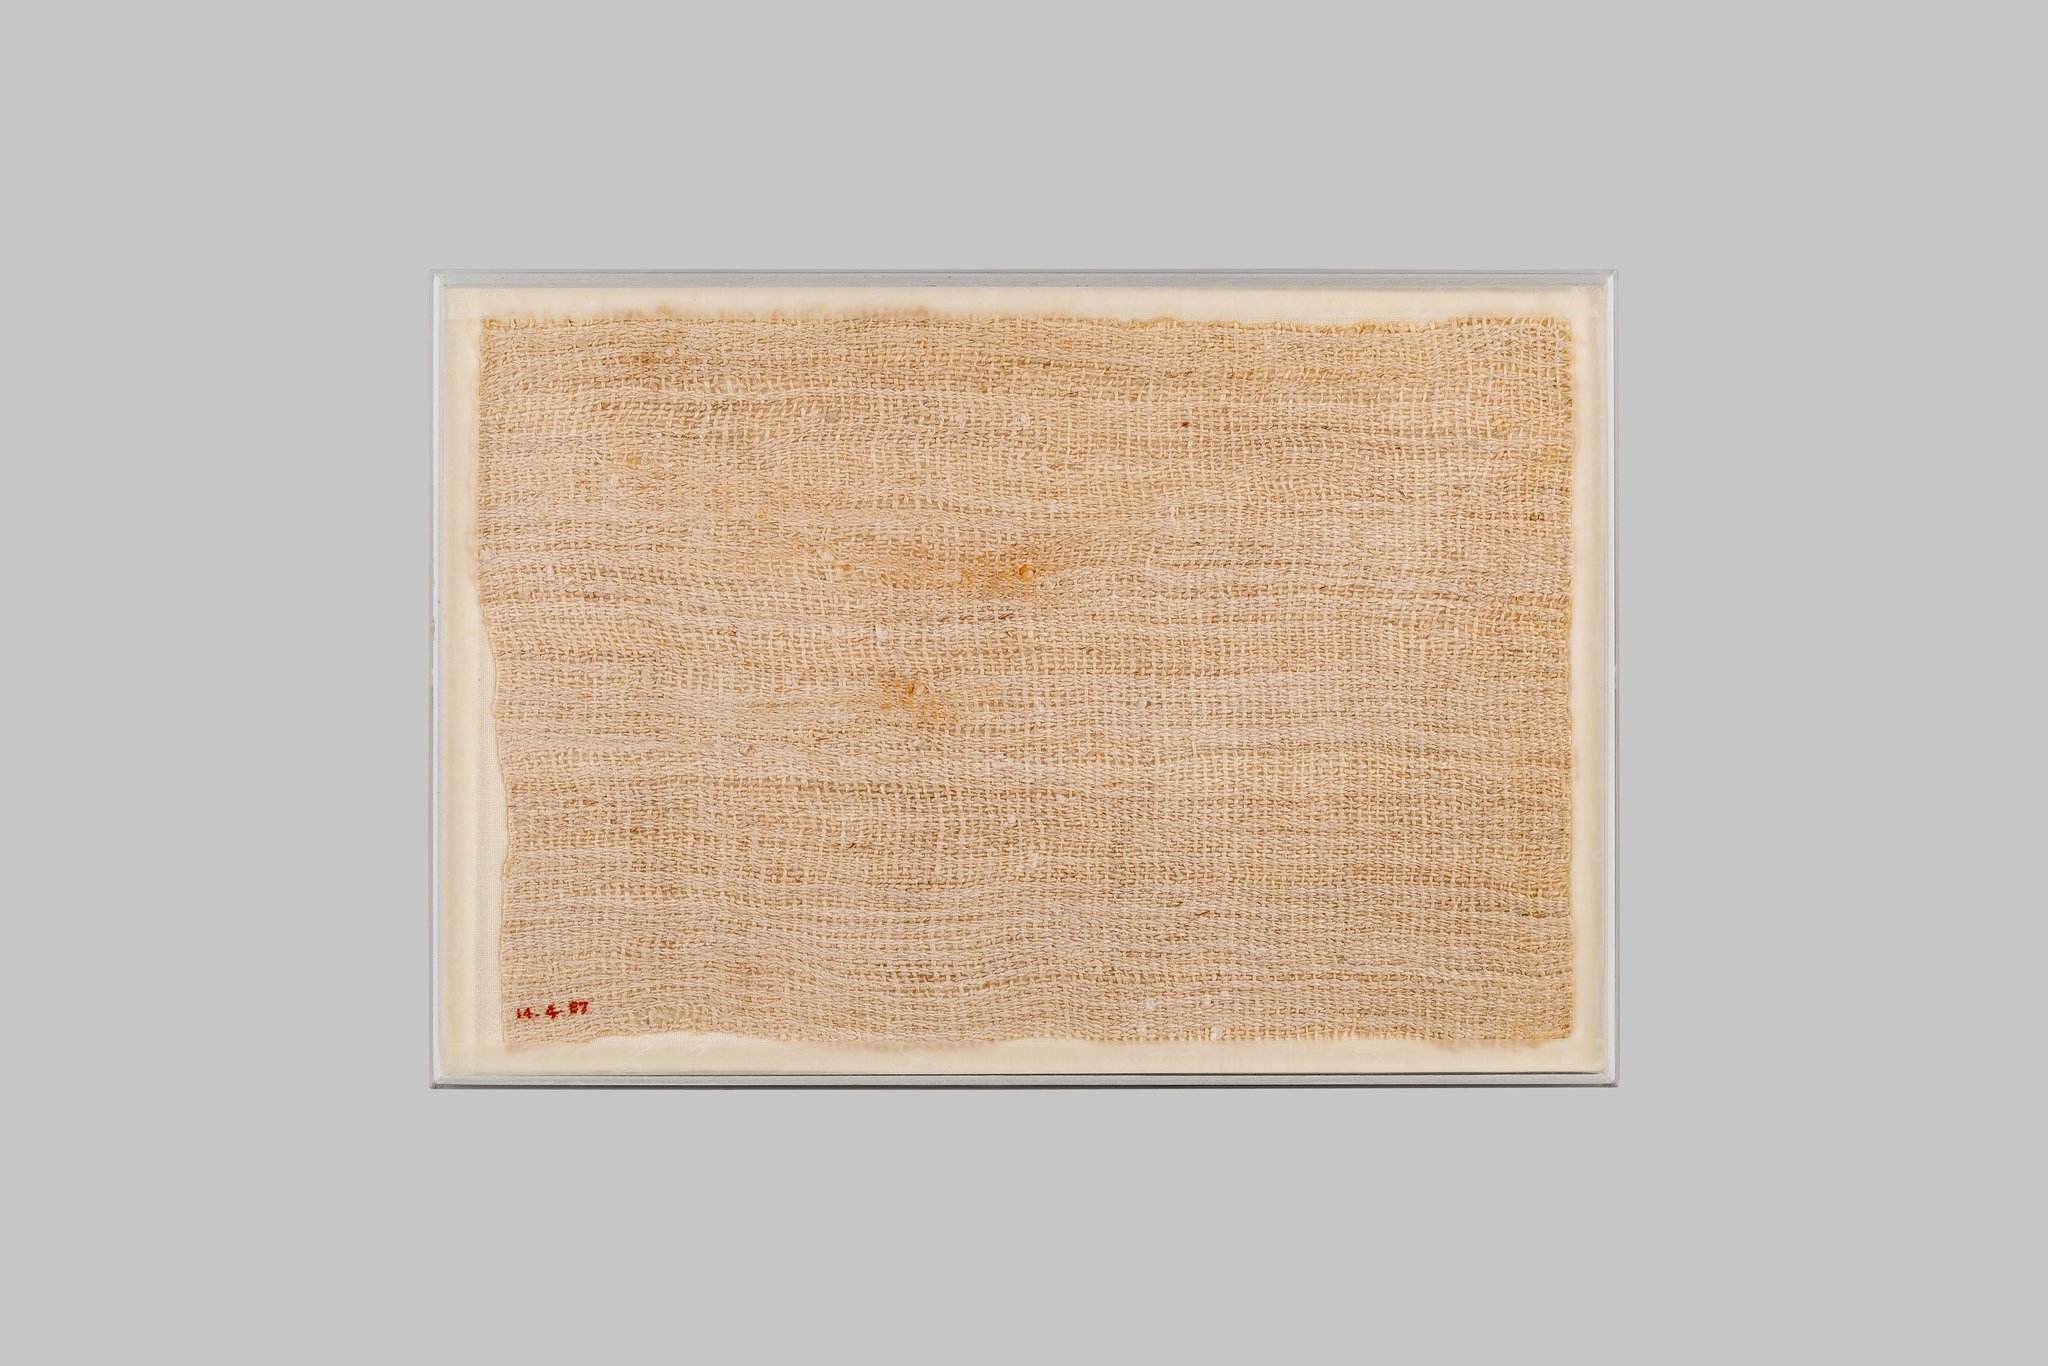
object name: linen fragment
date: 2880-2465 BCE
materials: linen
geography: egypt